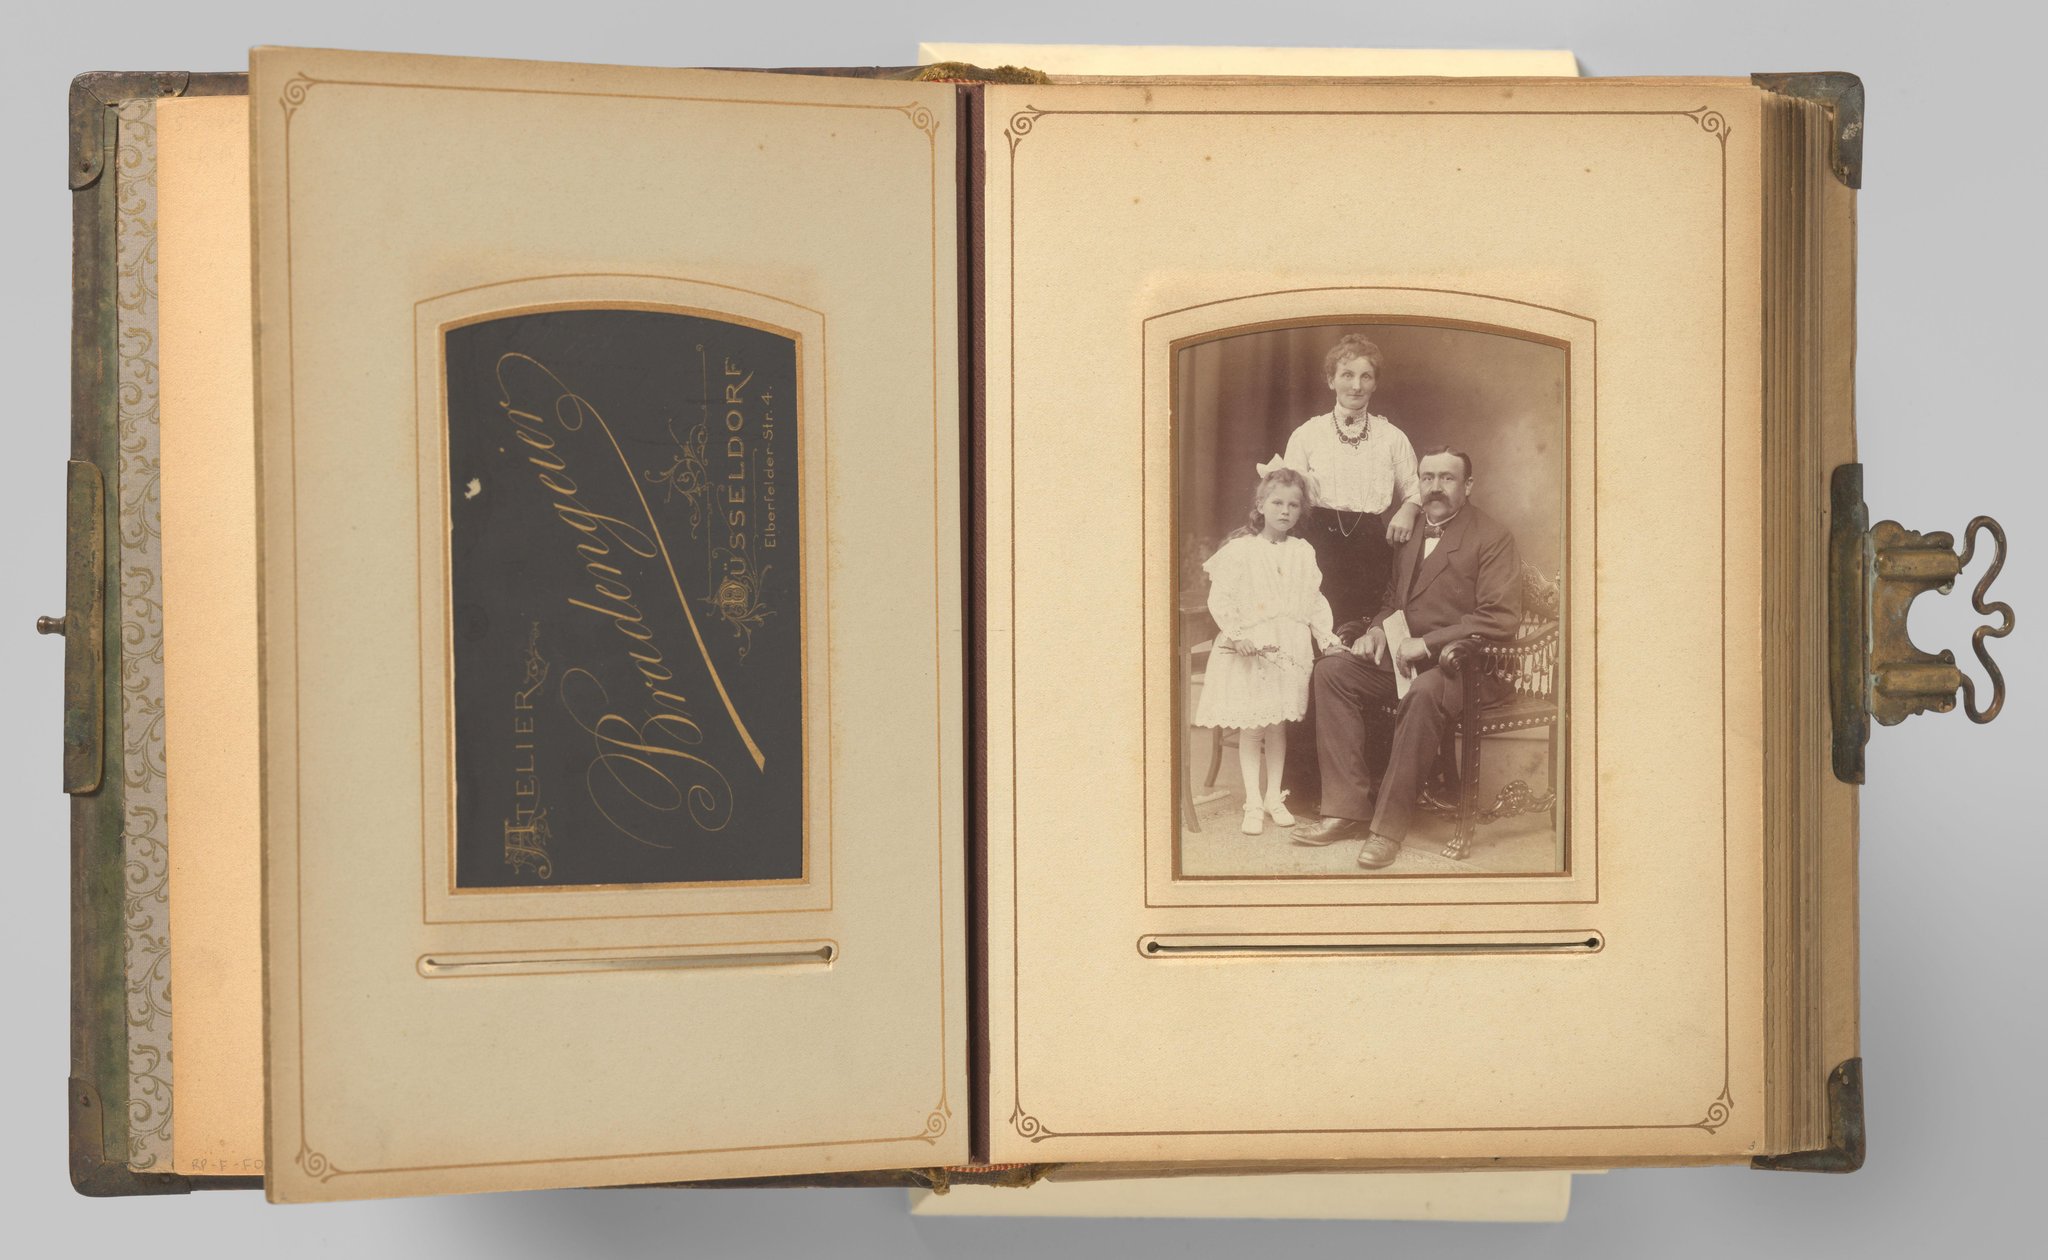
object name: photograph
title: Portret van een staande vrouw, een zittende man en een staand meisje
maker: Anonymous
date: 1860-1900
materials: cardboard, photographic support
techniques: albumen print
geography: germany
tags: sitting figure, historical persons - bb - woman, historical persons, girl (child between toddler and youth), standing figure - aa - female human figure